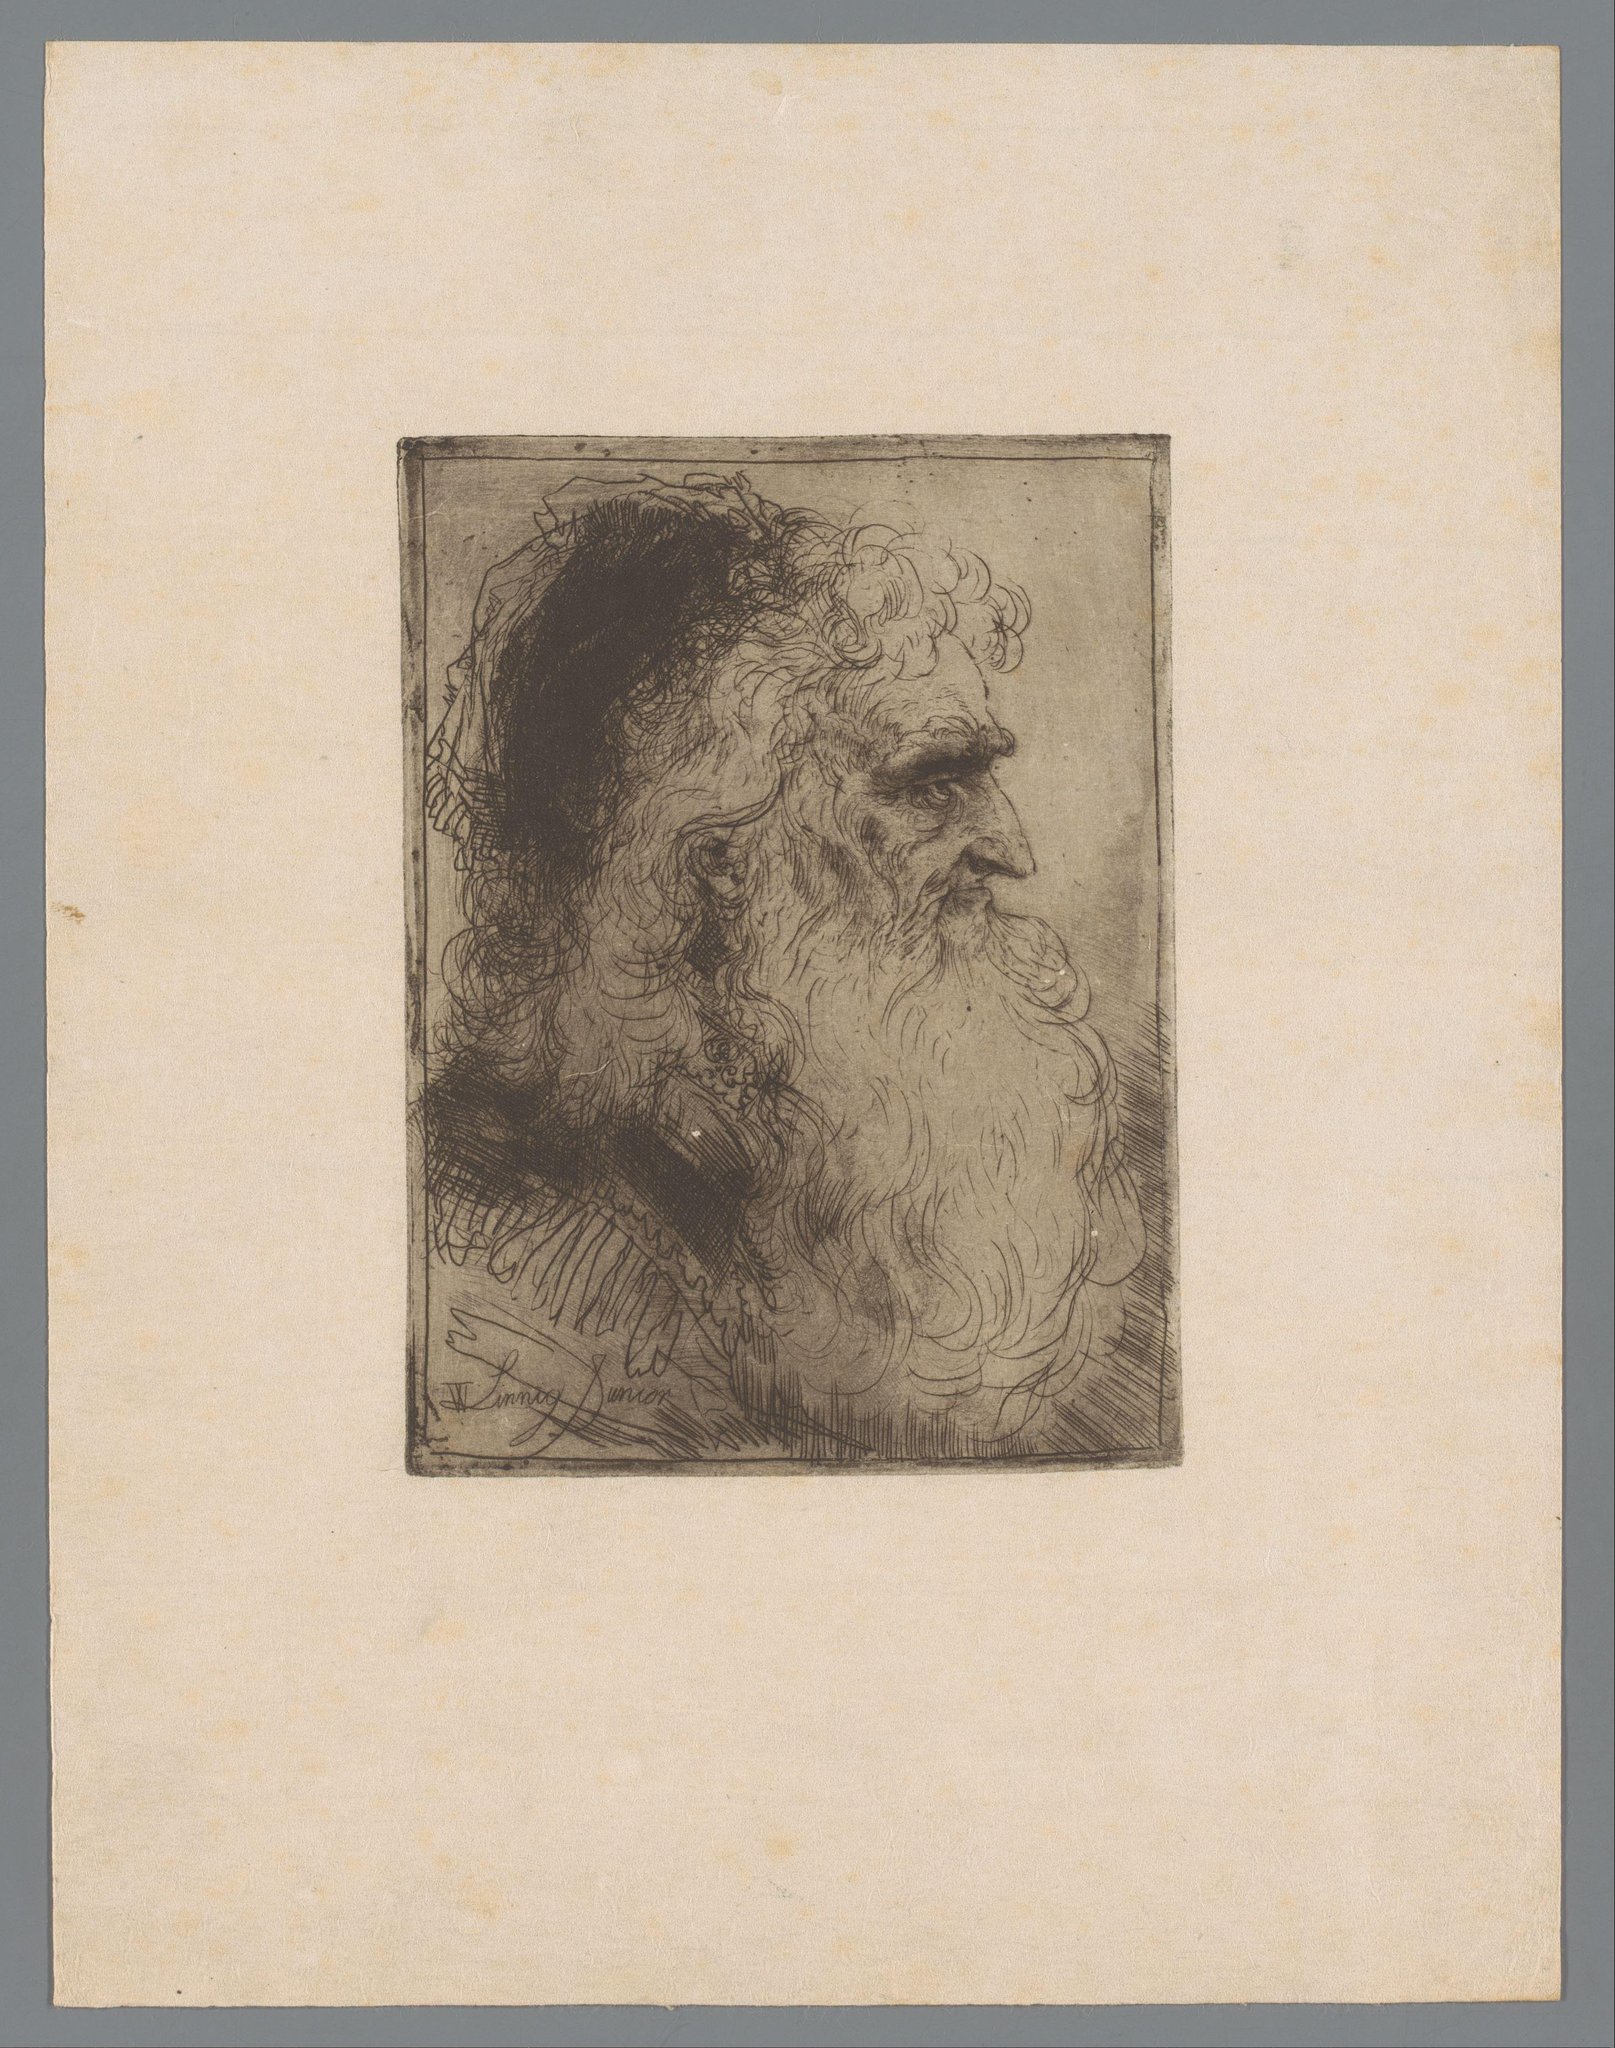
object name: print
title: Portret van een oude man met lange baard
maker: willem linnig (ii)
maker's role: print maker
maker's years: 1842-1890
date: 1852-1890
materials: paper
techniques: aquatint, drypoint, etching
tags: anonymous historical person portrayed alone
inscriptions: collector's mark: Lugt 2228